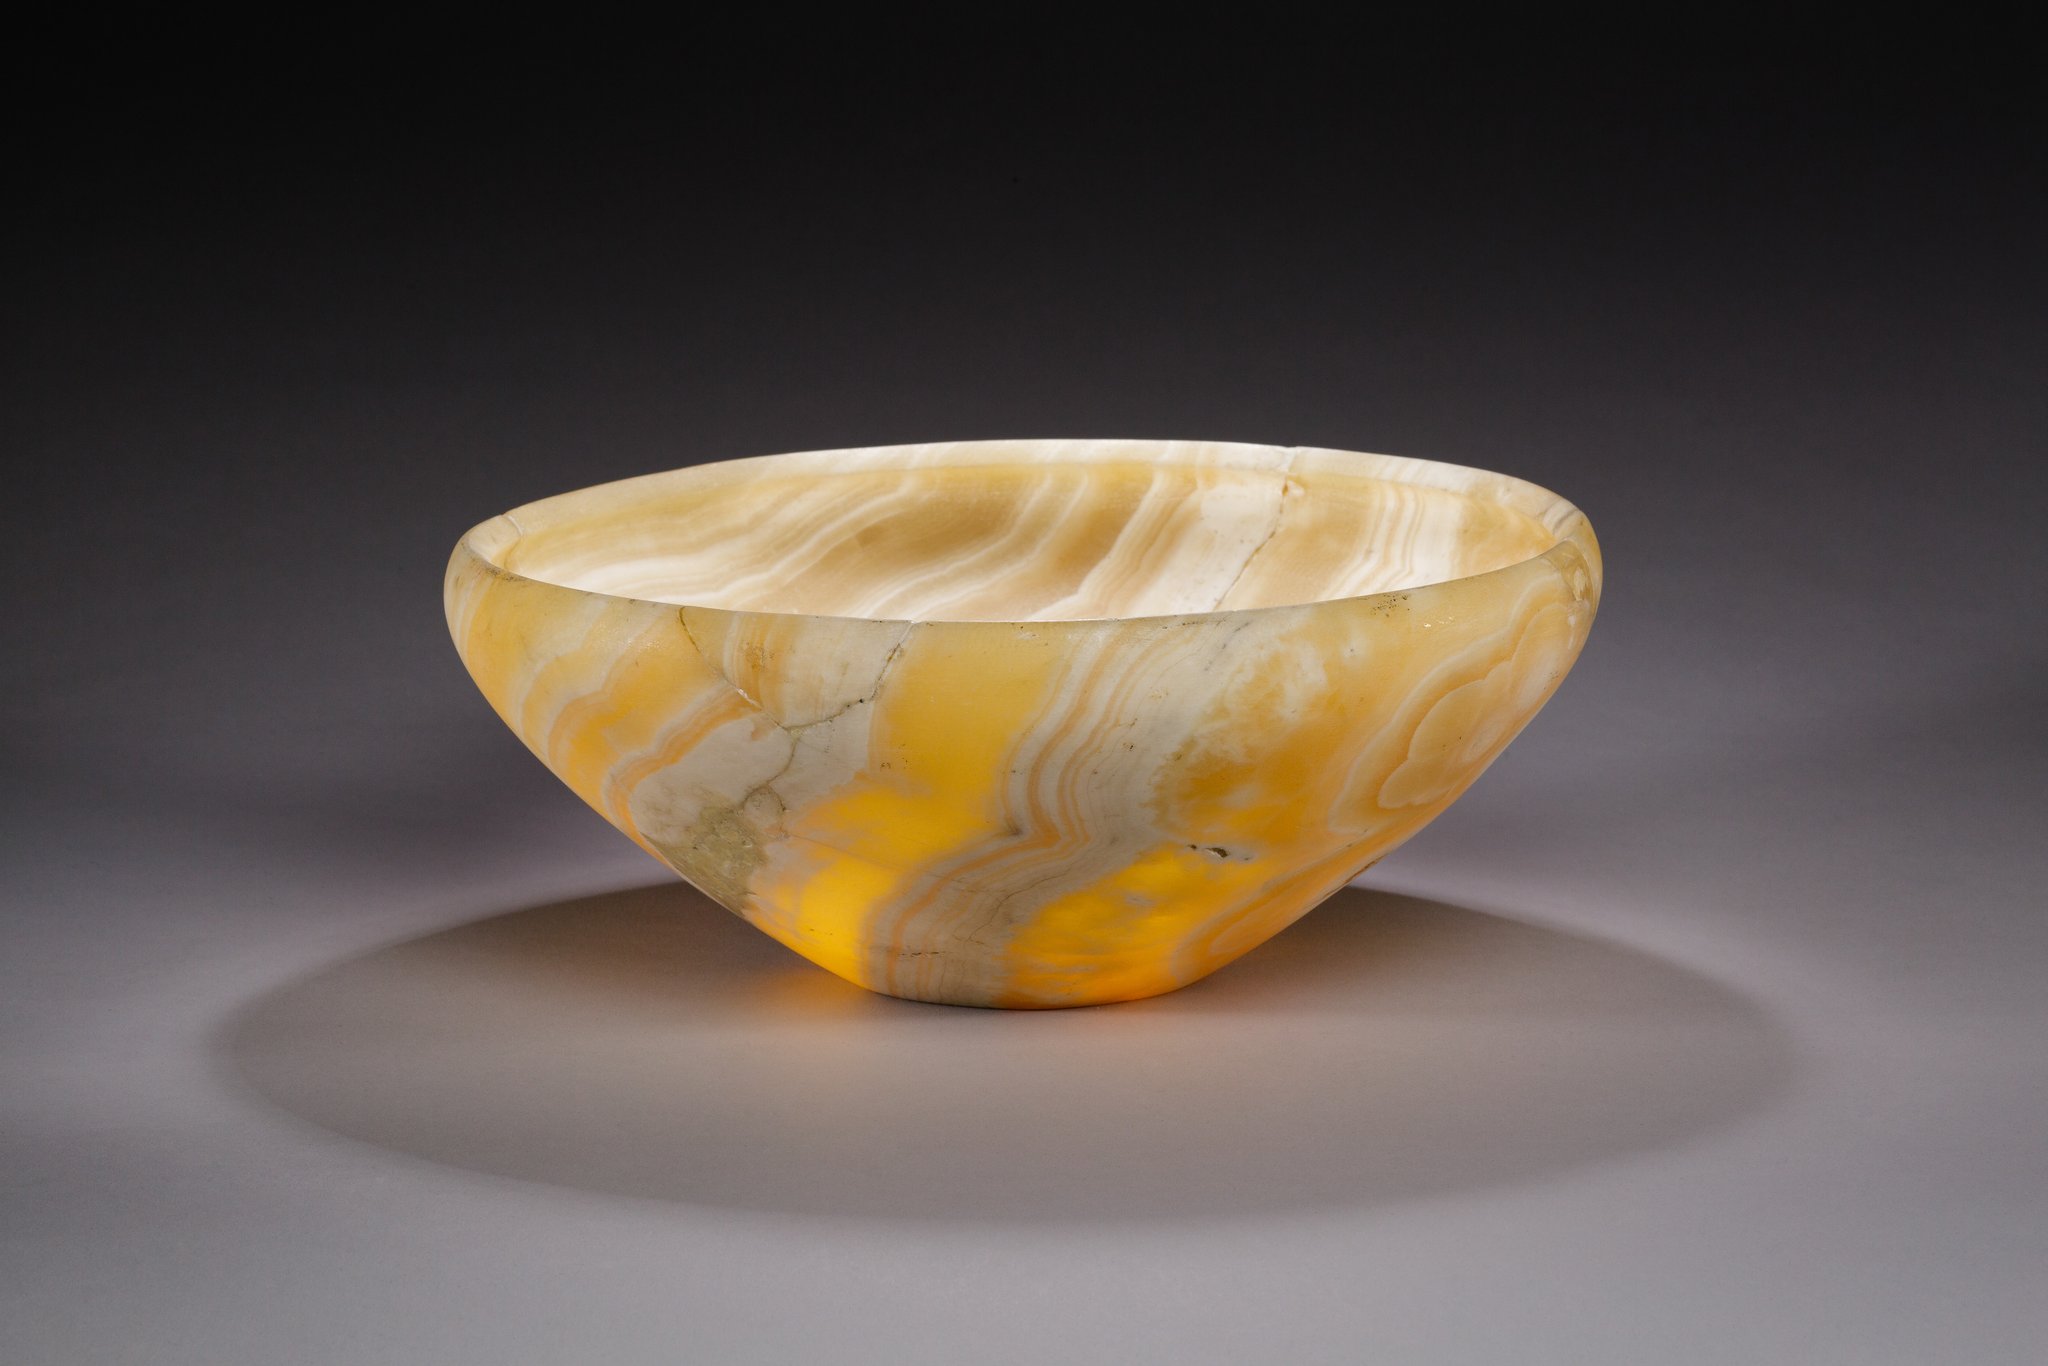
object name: bowl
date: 2750-2649 BCE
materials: stone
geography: egypt